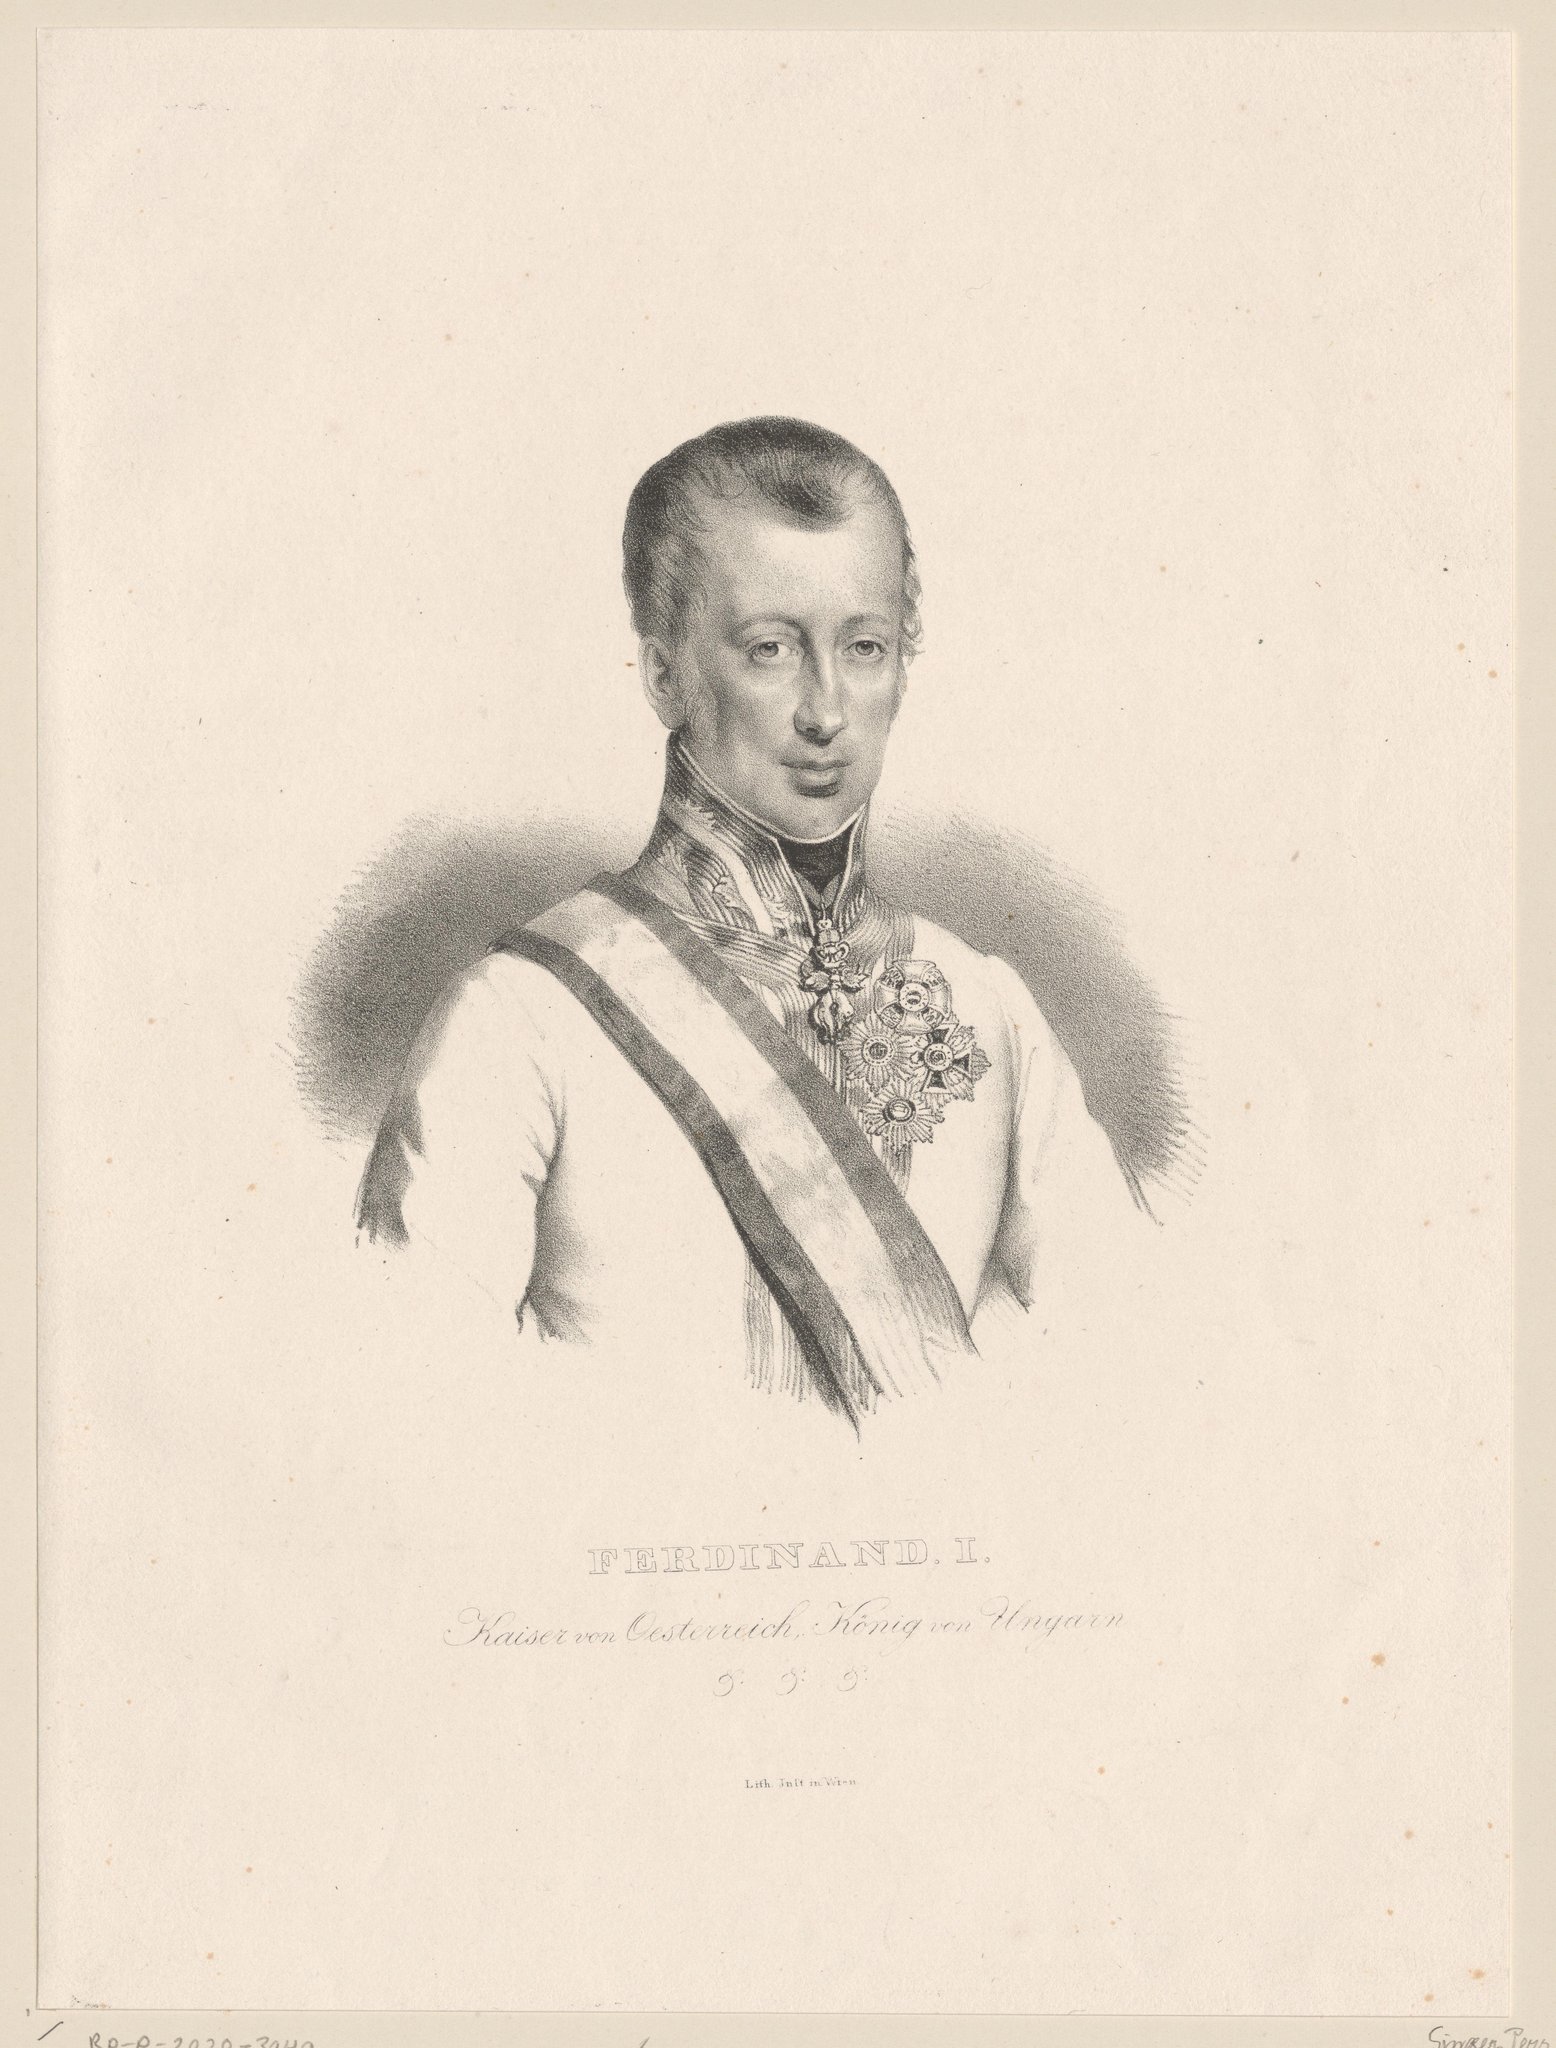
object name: print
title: Portret van Ferdinand I van Oostenrijk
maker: Anonymous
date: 1835-1848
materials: paper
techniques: lithograph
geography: vienna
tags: vienna, ferdinand i (keizer van oostenrijk), historical persons, knighthood order of the golden fleece, emperor